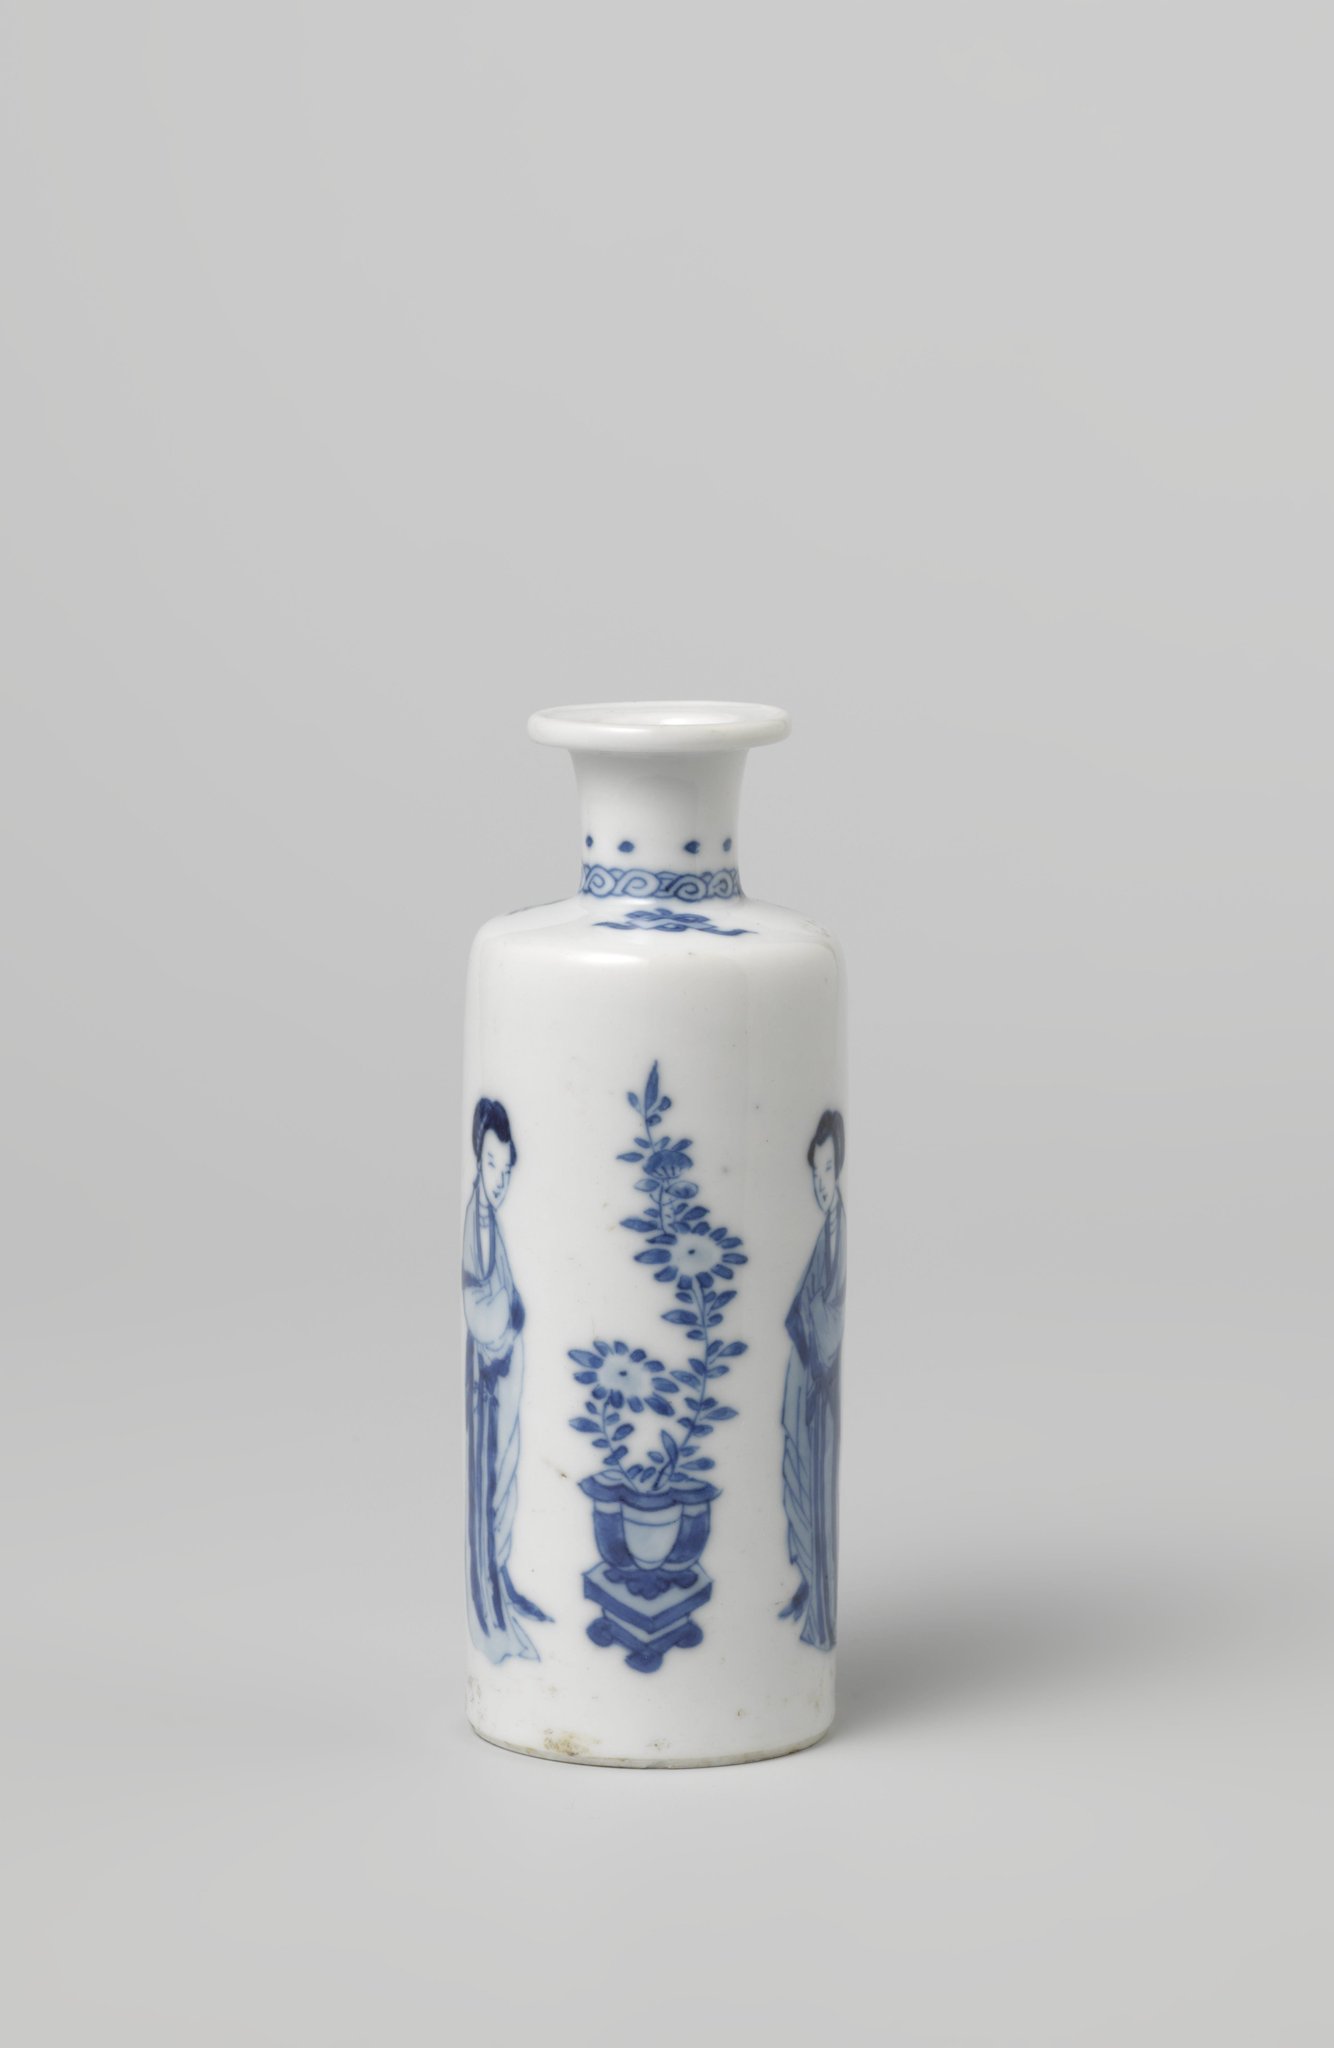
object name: vase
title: Small cilindrical vase with two women and auspicious symbols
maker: Anonymous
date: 1680-1720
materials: cobalt, glaze, paint, porcelain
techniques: firing, turning, vitrification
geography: china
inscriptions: mark: ‘成 化 年 製’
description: AK-NM-6726 Kleine vaas • Blauw-wit Kangxi-porselein • Onderdeel van Royers porseleincollectie Zie voor deze vaas de toelichting bij AK-NM-6723. Anders dan bij AK-NM-6723 worden de lijzen-en-een-pot-bloeiende-planten hier echter gecombineerd met oude bronzen vaten. Voor een bespreking van dit element, zie AK-NM-6769. Dit vaasje (AK-NM-6726) is gemerkt met een vierkaraktermerk van de Chenghua-keizer. Er komt in zo’n klein vaasje veel samen. De betekenisvolle beschildering van lijzen, bloeiende bloempotten en archaïsche vazen, de mogelijk Europese vorm, de evidente productiesnelheid gecombineerd met een hoge kwaliteit. Het Chenghua-merk is een mooie aanvulling. Porselein uit de Chengua-periode (1464-1487) wordt gezien als een hoogtepunt van het Chinese blauw-wit. Merken van keizersperioden waren eigenlijk niet toegestaan op Chinees porselein dat níet voor het hof werd gemaakt. Maar aan deze verordening hield men zich niet. Zeker voor porselein dat werd verscheep naar Europa maakte het weinig uit. Het is boeiend dat de porseleinschilders dit merk erop zetten, een aanbeveling van de kwaliteit, dat – zoals met zoveel zaken die op het porselein geschilderd werden – in Europa nauwelijks begrepen werden. Hooguit droegen de niet te lezen karakters bij aan de algemene exotische aantrekkelijkheid [zie voor deze kwestie Van Noord 2020]. Twee identieke exemplaren bevonden zich in de collectie van B.J.V. van Hees (1873-1953), een van de belangrijke Nederlandse porseleinverzamelaars uit het begin van de 20ste eeuw [Cheng 2009, nrs. 38 en 39]. Bronnen: Cheng Xiejun (red.), Traces of the trade: Chinese export porcelain donated by Henk B. Nieuwenhuys (tent.cat. Shanghai Museum), Shanghai, 2009. Willemijn van Noord, ‘Between Script and Ornament: Delftware Decorated with Pseudo-Chinese Characters, 1680–1720’, Journal of Design History 34/1 (2020), Oxford University Press (online).